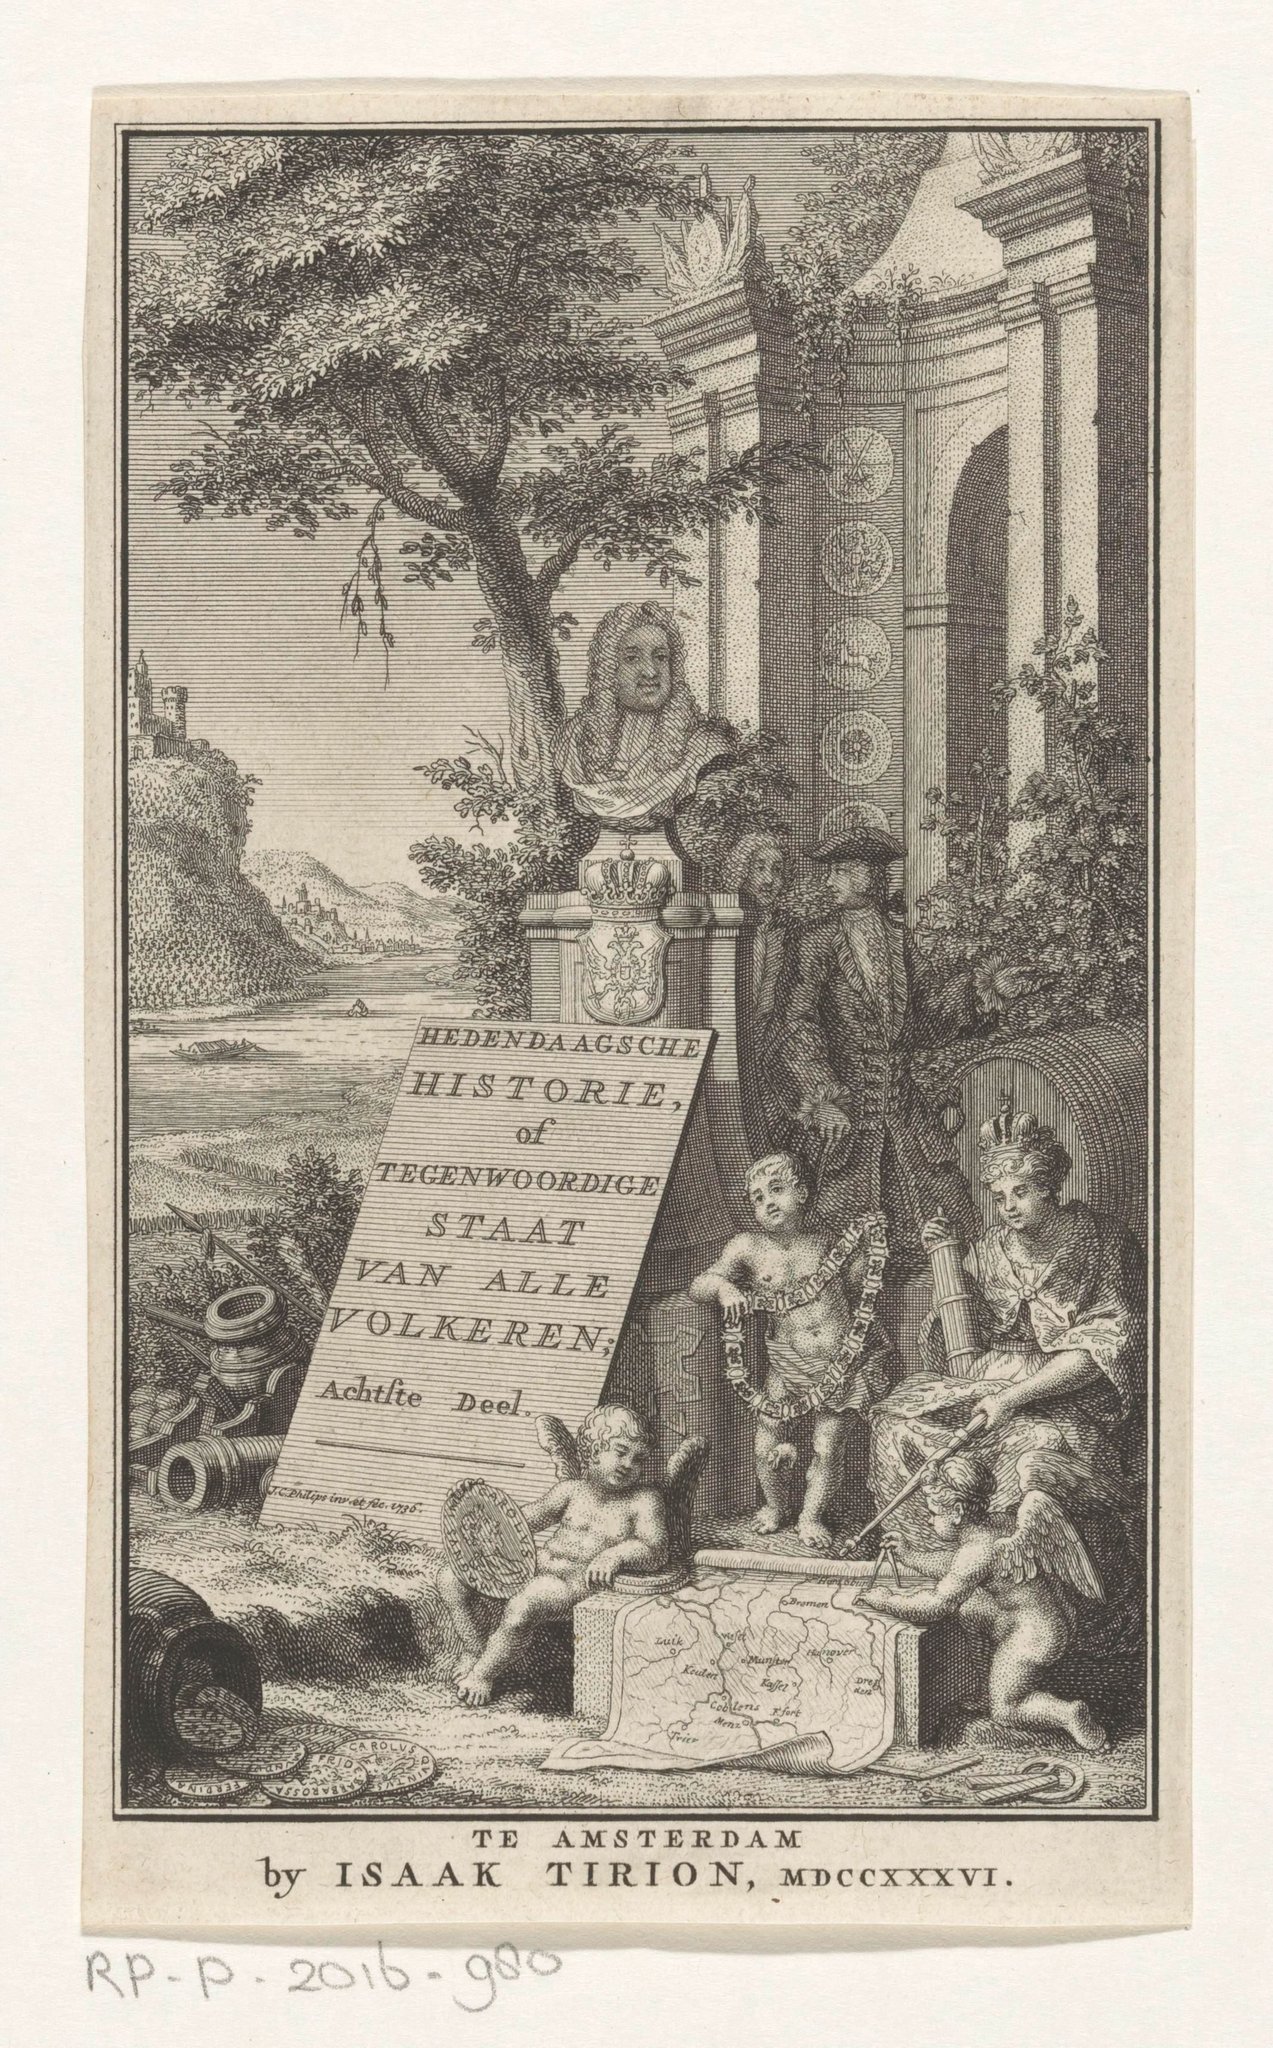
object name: titelblad, titelpagina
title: Titelpagina voor: Thomas Salmon, Hedendaagsche historie of tegenwoordige staat van alle volkeren, VIII Deel, 1736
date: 1736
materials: paper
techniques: engraving, etching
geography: amsterdam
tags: charlemagne (holy roman emperor), maps, atlases, cupids: 'amores', 'amoretti', 'putti', germany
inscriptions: collector's mark: Lugt 2228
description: Putti met passer, portretmedaillon van Karel de Grote en de ordeketting van het Gulden Vlies rondom een kaart van (een deel van) het Duitse Rijk. Bij hen zit een gekroonde vrouw met scepter. Links ligt een kruik met portretmedaillons met heersers van het Duitse Rijk. In het midden een buste van een Duitse vorst, waarachter twee West-Europeanen staan. In de achtergrond zich op een stad in een berglandschap aan het water.